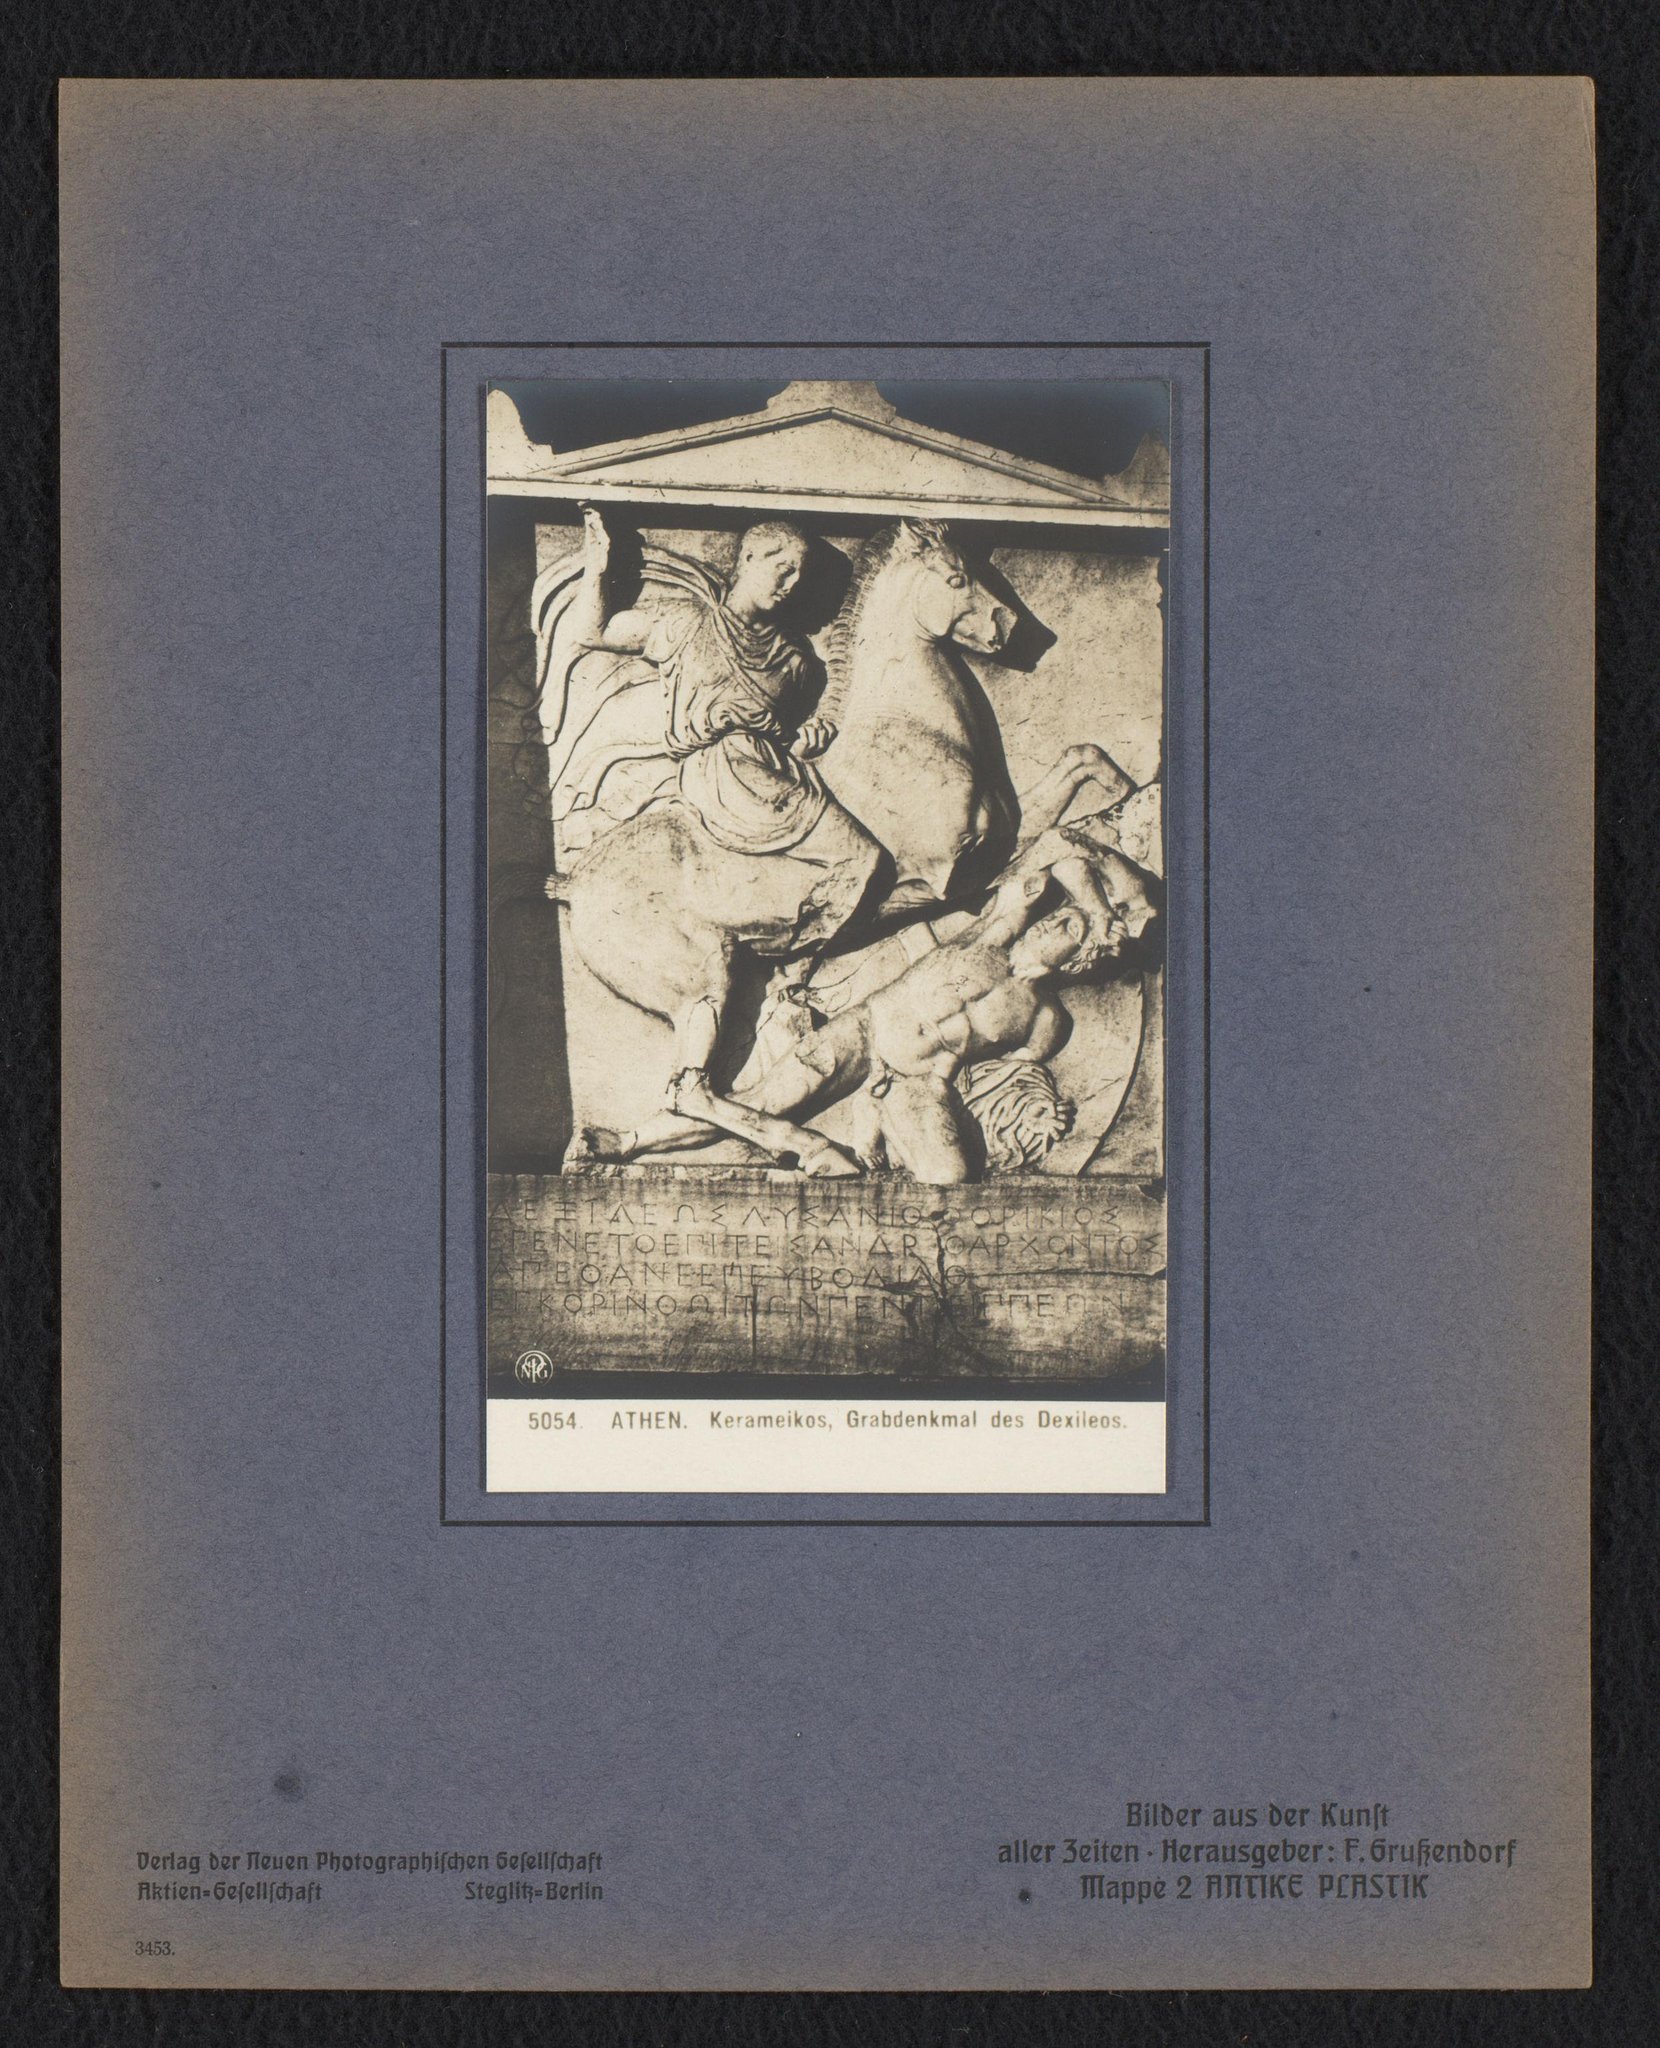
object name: photograph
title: Athen, Kerameikos, Grabdenkmal des Dexileos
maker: Anonymous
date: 1906-1911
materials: paper, cardboard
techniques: gelatin silver print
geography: steglitz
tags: sculpture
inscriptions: number: ‘5054.’